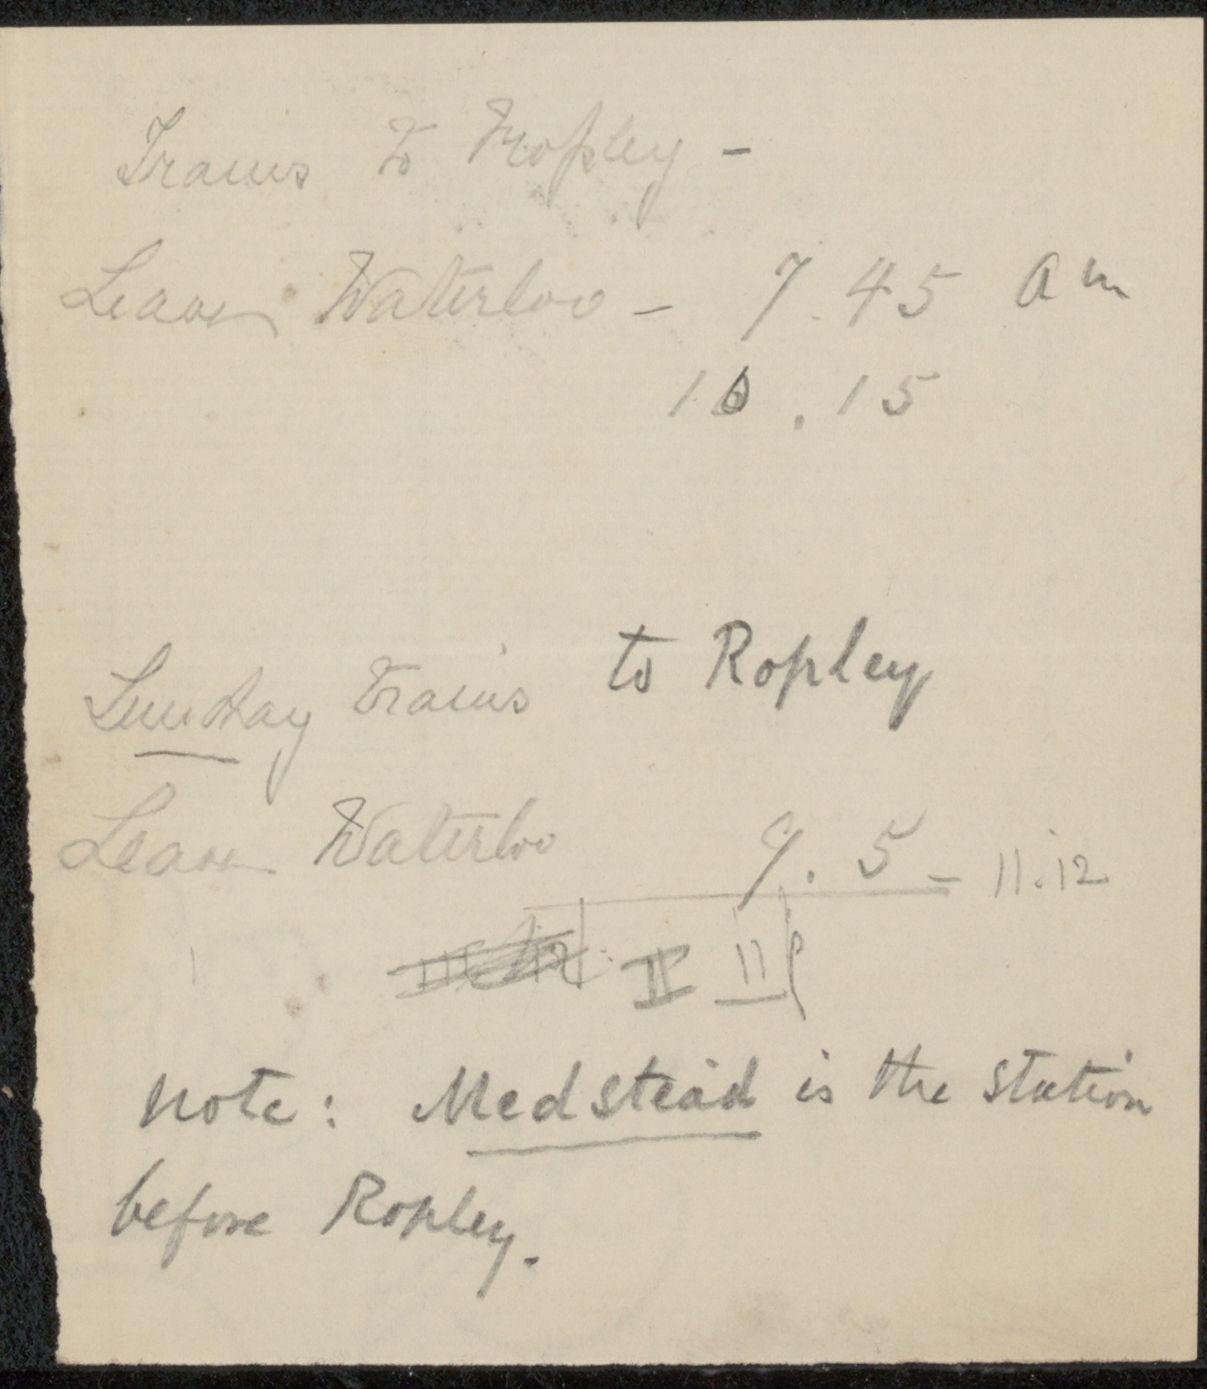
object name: aantekening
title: Aantekening uit archief Philip Zilcken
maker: Anonymous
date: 1867-1982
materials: paper, pencil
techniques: writing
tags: the hague, painter, draughtsman, philip zilcken, london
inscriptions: watermark